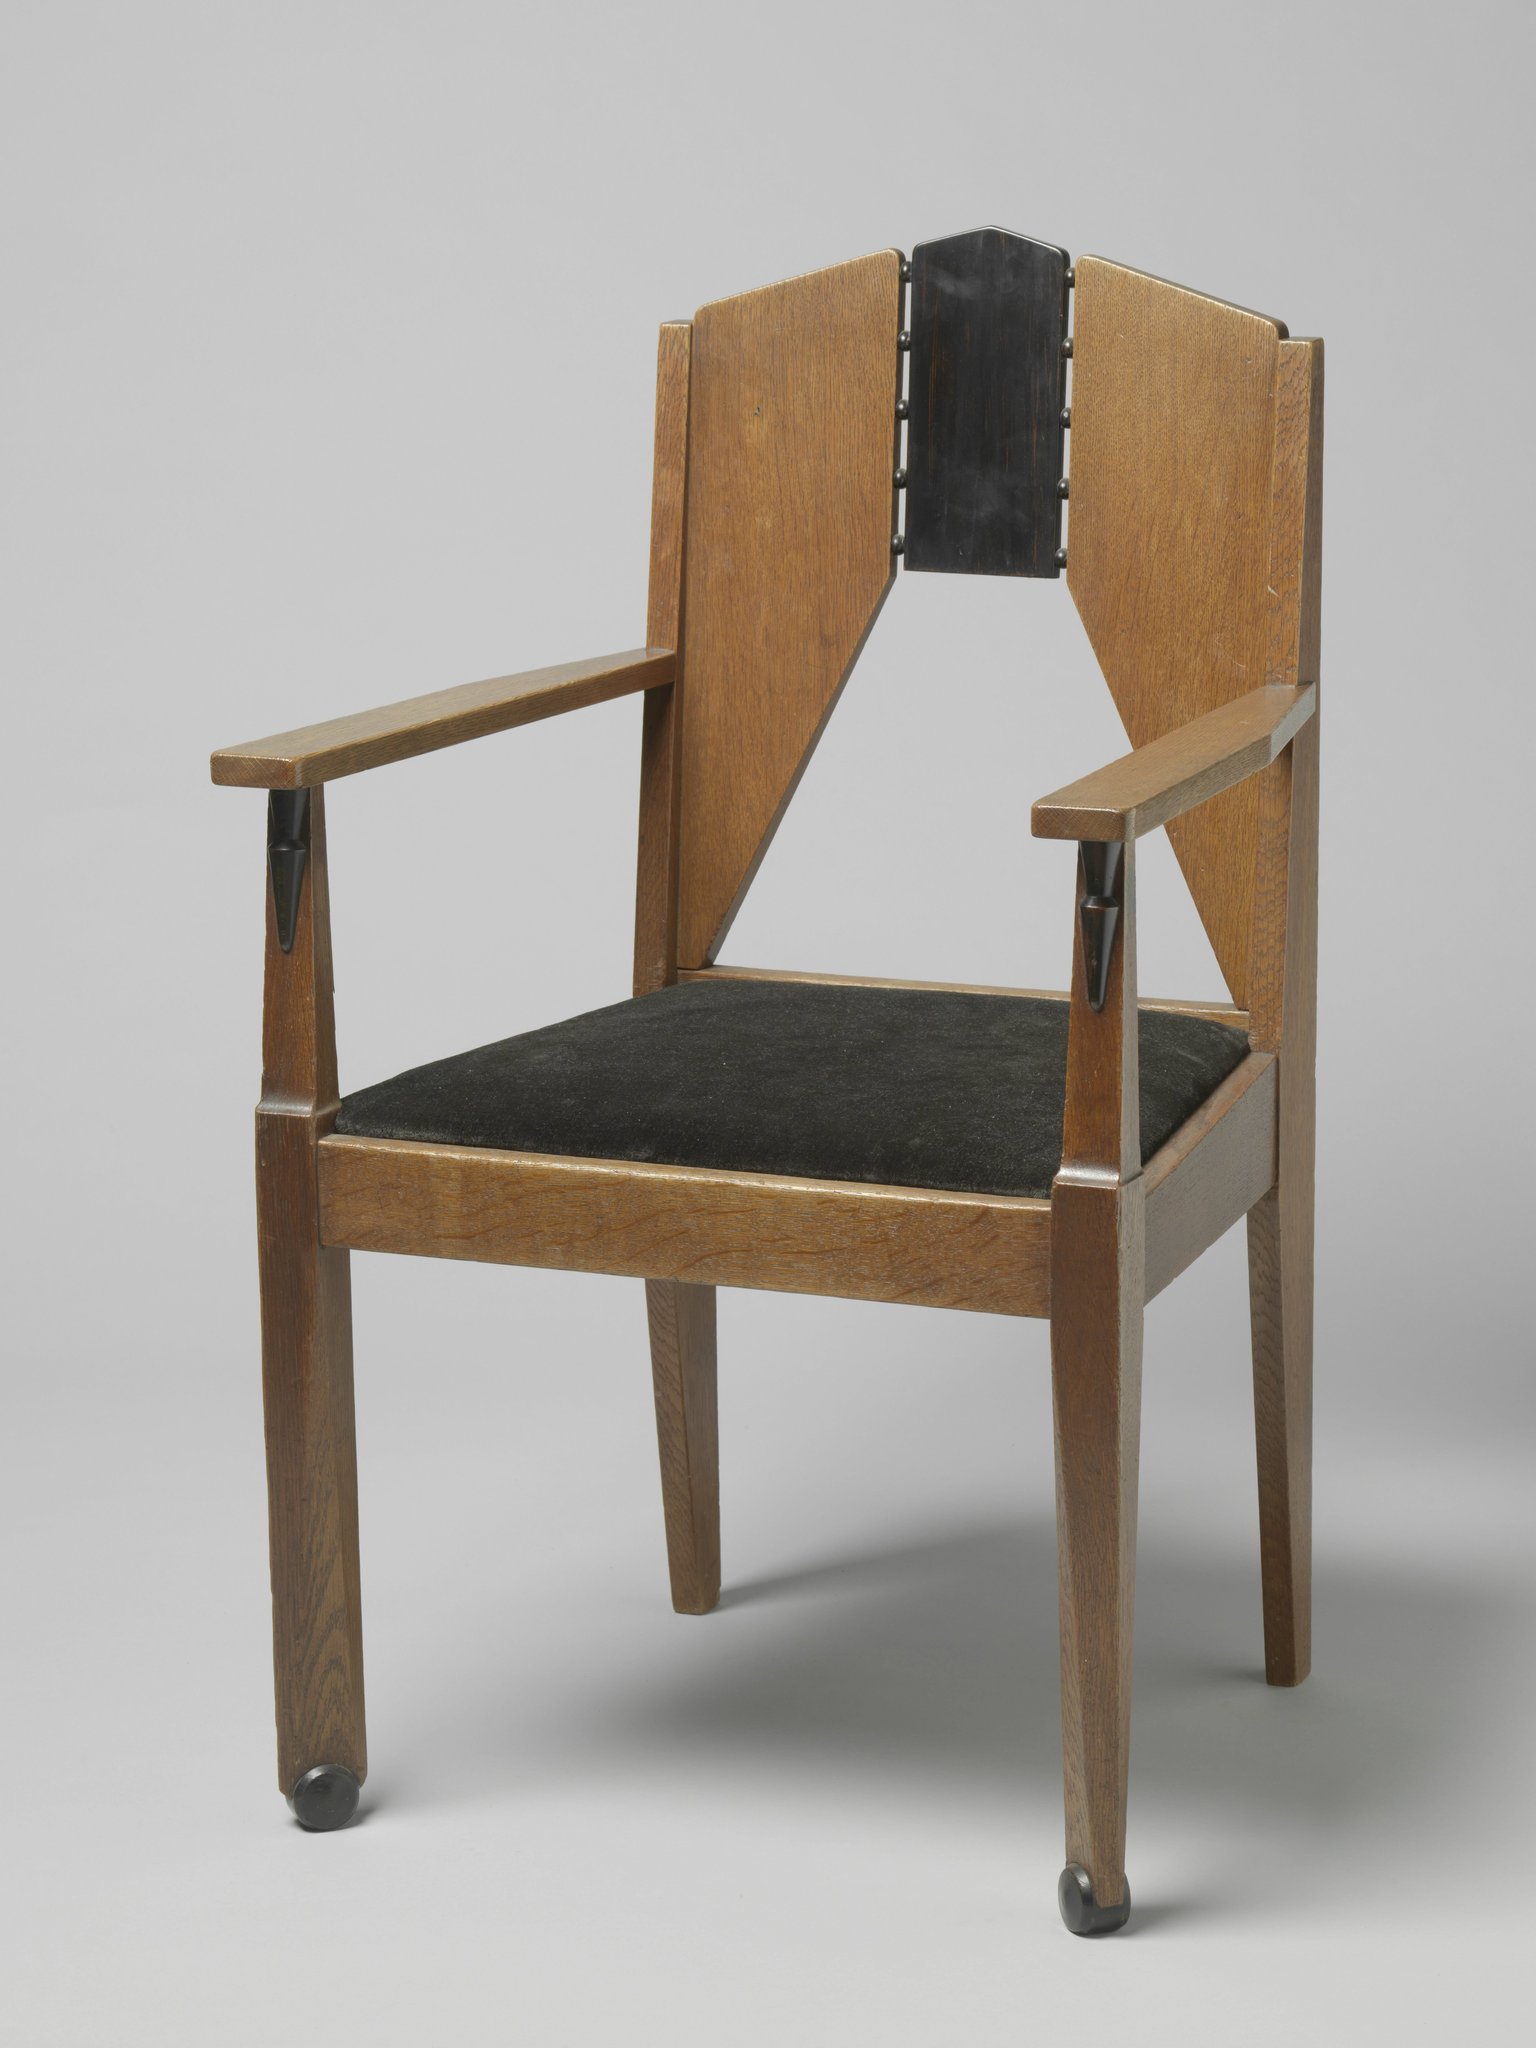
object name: furniture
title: Armstoel met trapeziumvormige open ruimte in de rugleuning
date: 1920-1930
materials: wood, textile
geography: amsterdam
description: Armstoel van eikenhout rustend op vier poten. De voorpoten zijn afgeschuind en rusten op zwart gebeitste schijven met bolle zijkanten. De voorpoten lopen door in de armstutten en bevatten net onder de armlegger een gebeeldhouwde zwart gebeitste druppelvorm. De achterpoten lopen door in de rugstijlen en verbreden vanaf onder waarna zij ter hoogte van het midden naar boven versmallen. De rugleuning is samengesteld uit drie panelen. Deze zijn zodanig gevormd dat aan de bovenzijde een driehoekige vorm en aan de onderzijde een open trapeziumvorm is ontstaan. De twee buitenste panelen worden door middel van vijf kralen aan iedere zijde verbonden aan het zwart gebeitste middenpaneel. De zitting is bekleed met zwarte trijp.